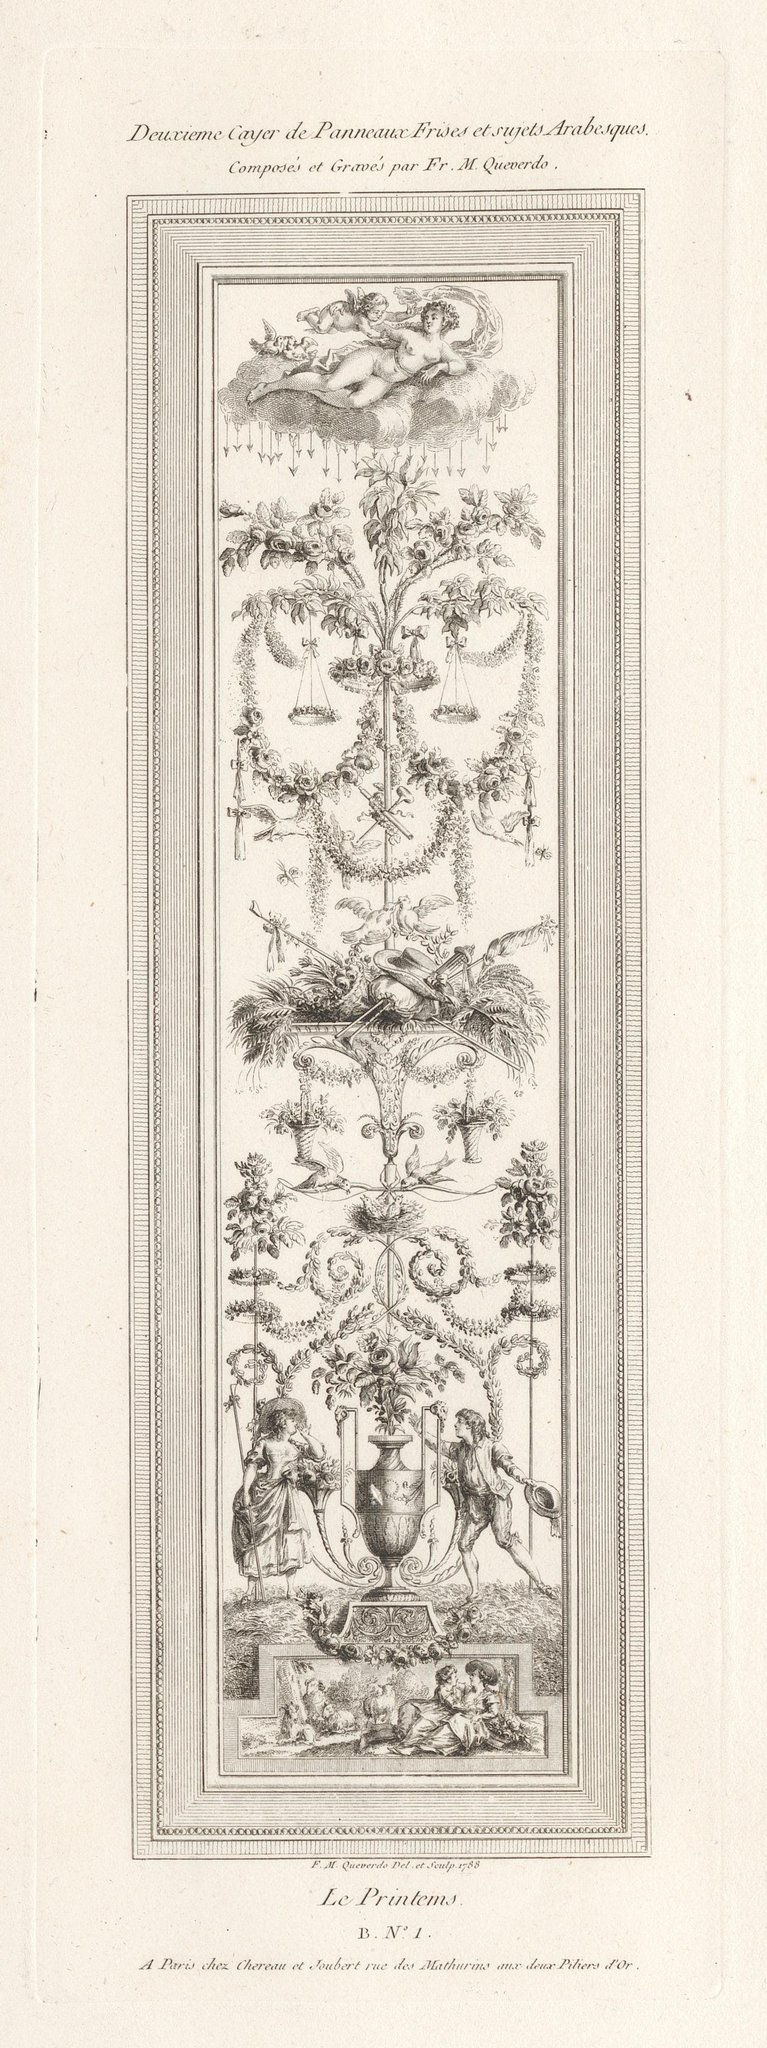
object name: ornament print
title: Premier cayer de panneaux, frises et sujets arabesques composés et gravés par Fr. M. Queverdo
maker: françois marie isidore queverdo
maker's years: 1748-1797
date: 1788-1802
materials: paper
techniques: etching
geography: paris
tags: water-pipe, hookah, narghile, tea-ceremony - cc - out of doors, asiatic races and peoples: turks, ornament ~ arabesque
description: Doordat dit album bestaat uit meerdere, deels eerder uitgegeven prentreeksen, is de datering niet consequent. Het geheel is op de titelpagina gedateerd op 1802. Deze reeks is gedateerd op 1788. De serietitel voor het gehele werk is "Recueil d'arabesques, contenant les loges du Vatican". De andere serietitel is de titel van de specifieke reeks binnen het geheel.